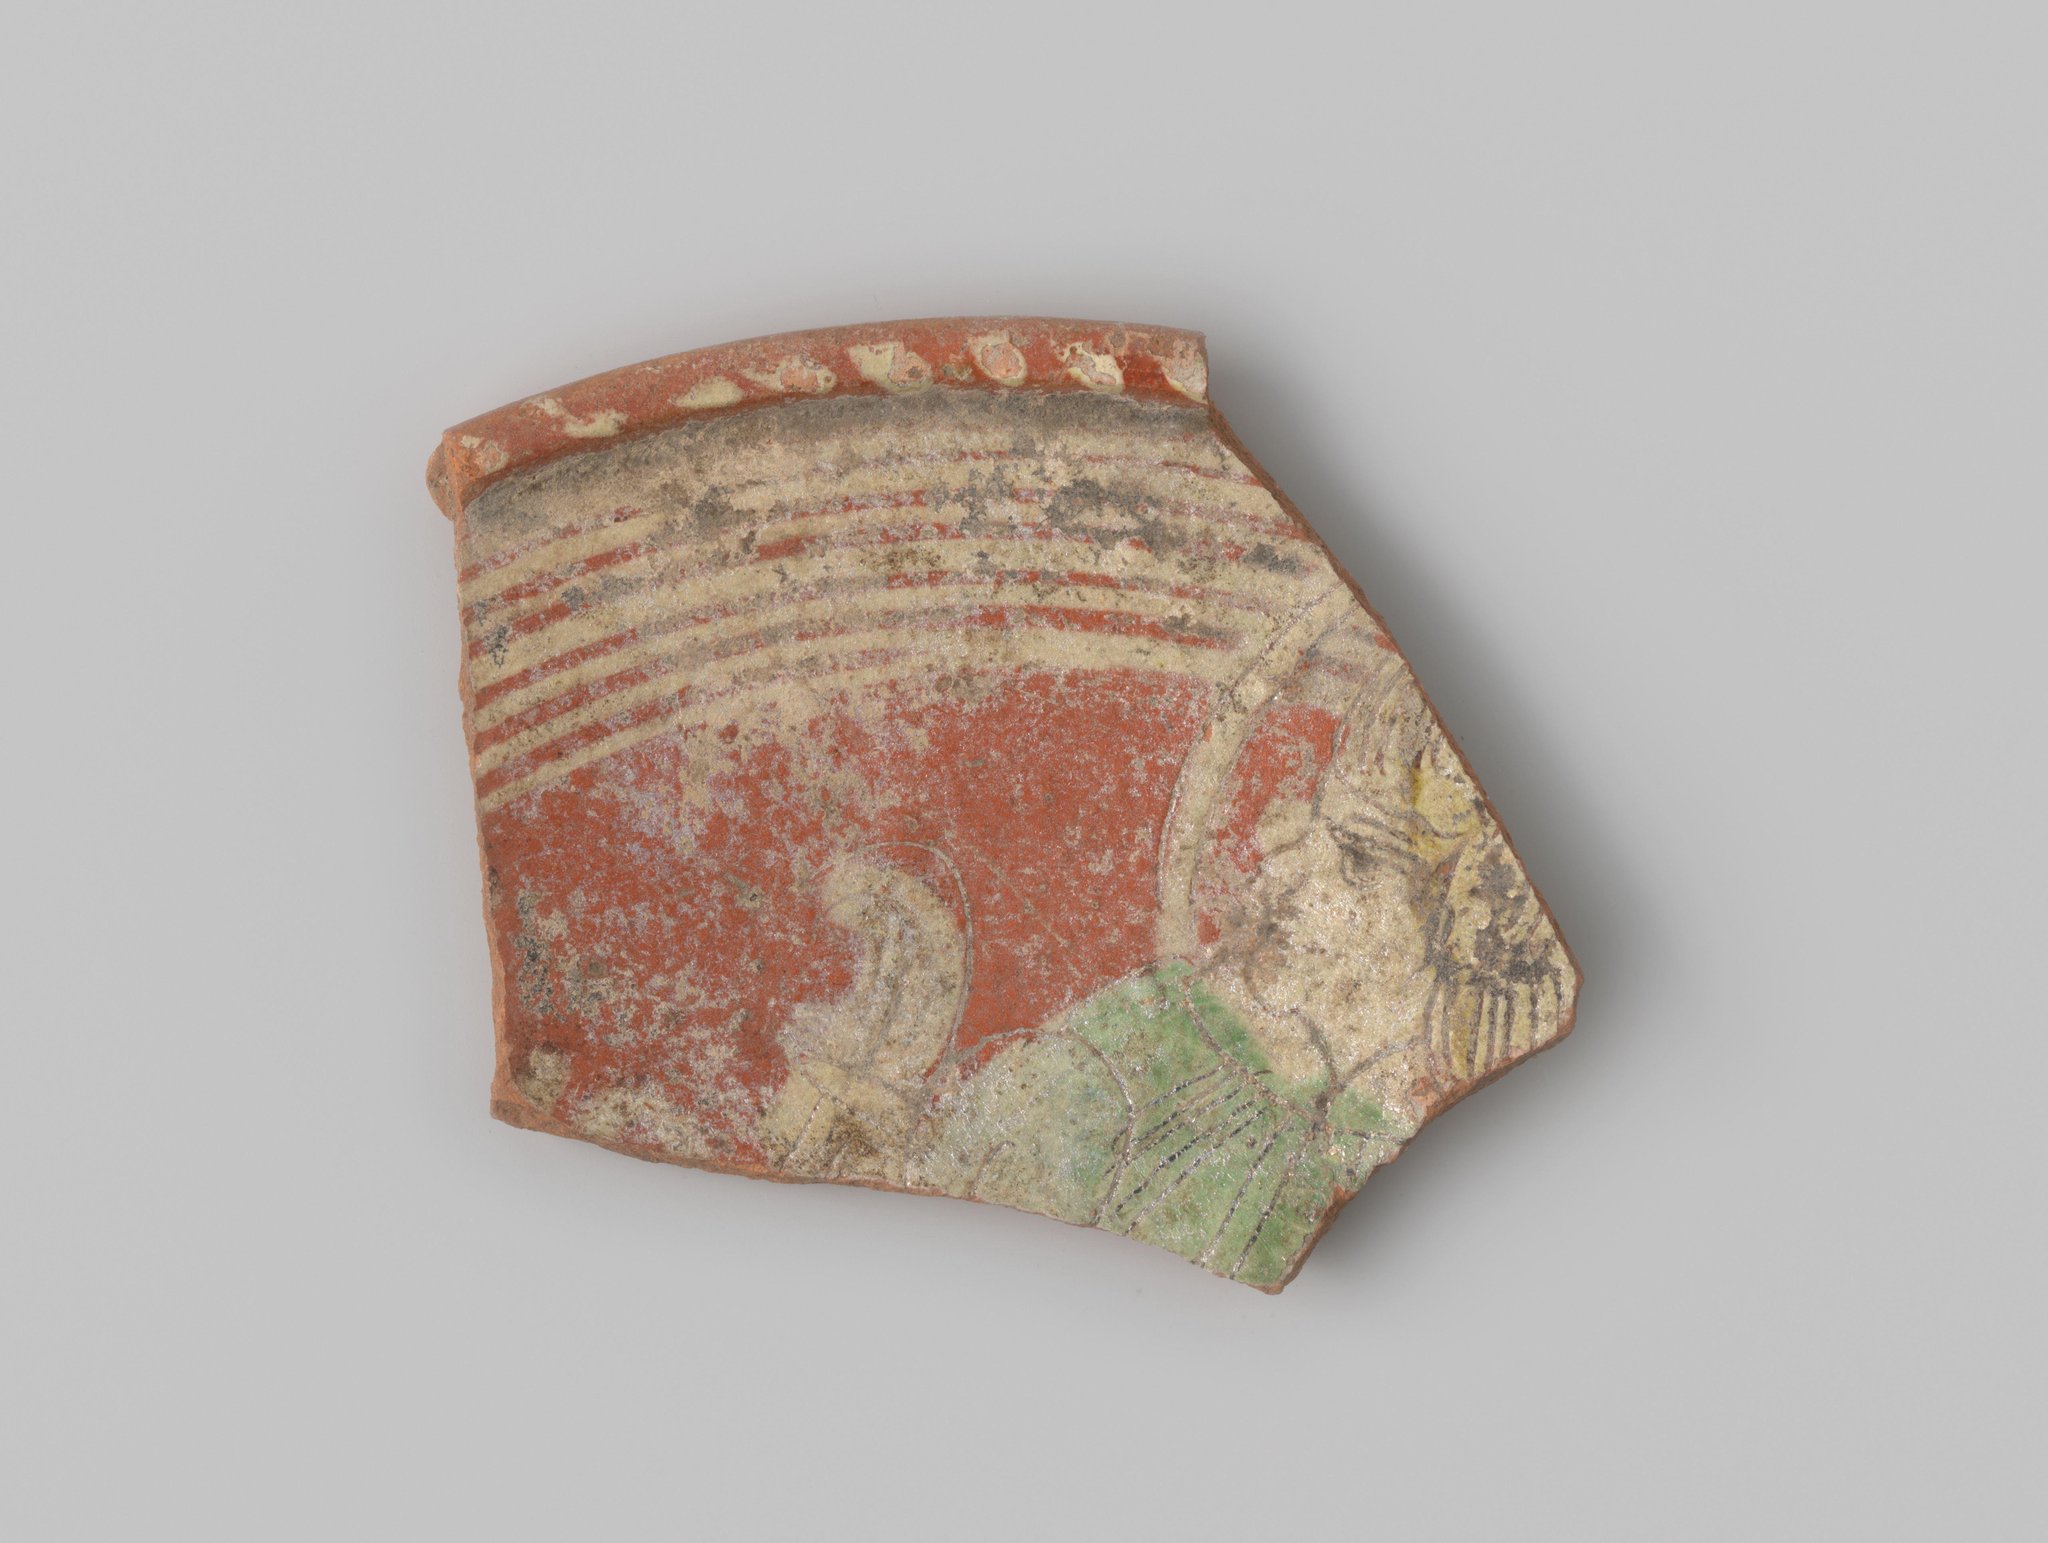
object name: sherd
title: Scherf van roodbakkend aardewerk voorzien van een tekening van een figuur en profil, met geel haar en groene kleding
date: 1500-1899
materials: earthenware, glaze